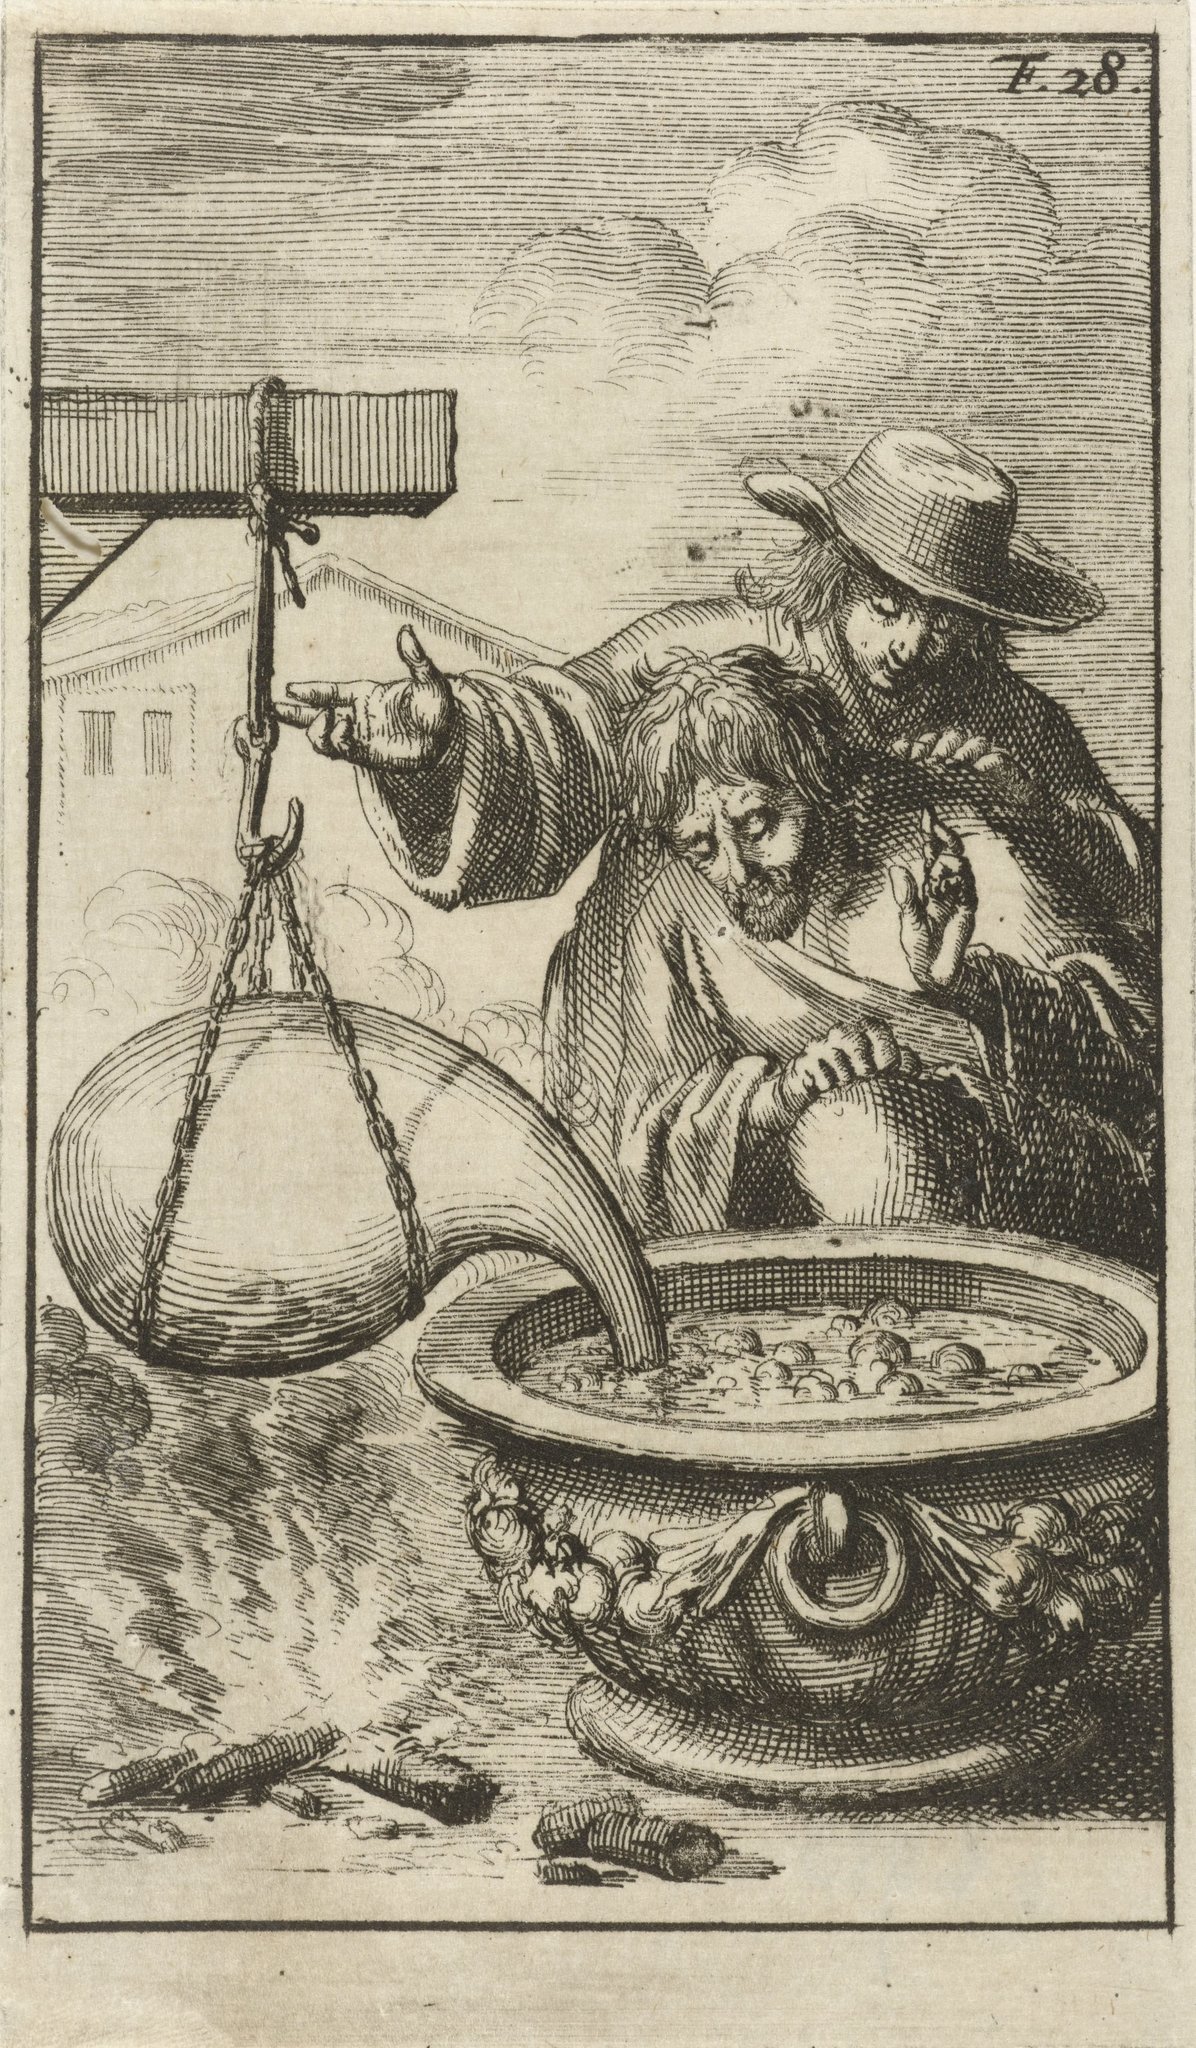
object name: book illustration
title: Twee mannen kijken aandachtig naar de bellen die in een koelvat met water door gassen veroorzaakt worden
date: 1688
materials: paper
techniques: etching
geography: amsterdam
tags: experiment, test ~ science and technology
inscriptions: collector's mark: Lugt 2228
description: Illustratie uit: Drebbel, Cornelis. Grondige oplossinge van de natuur en eygenschappen der elementen. Amsterdam: Jacob Claus, 1688.